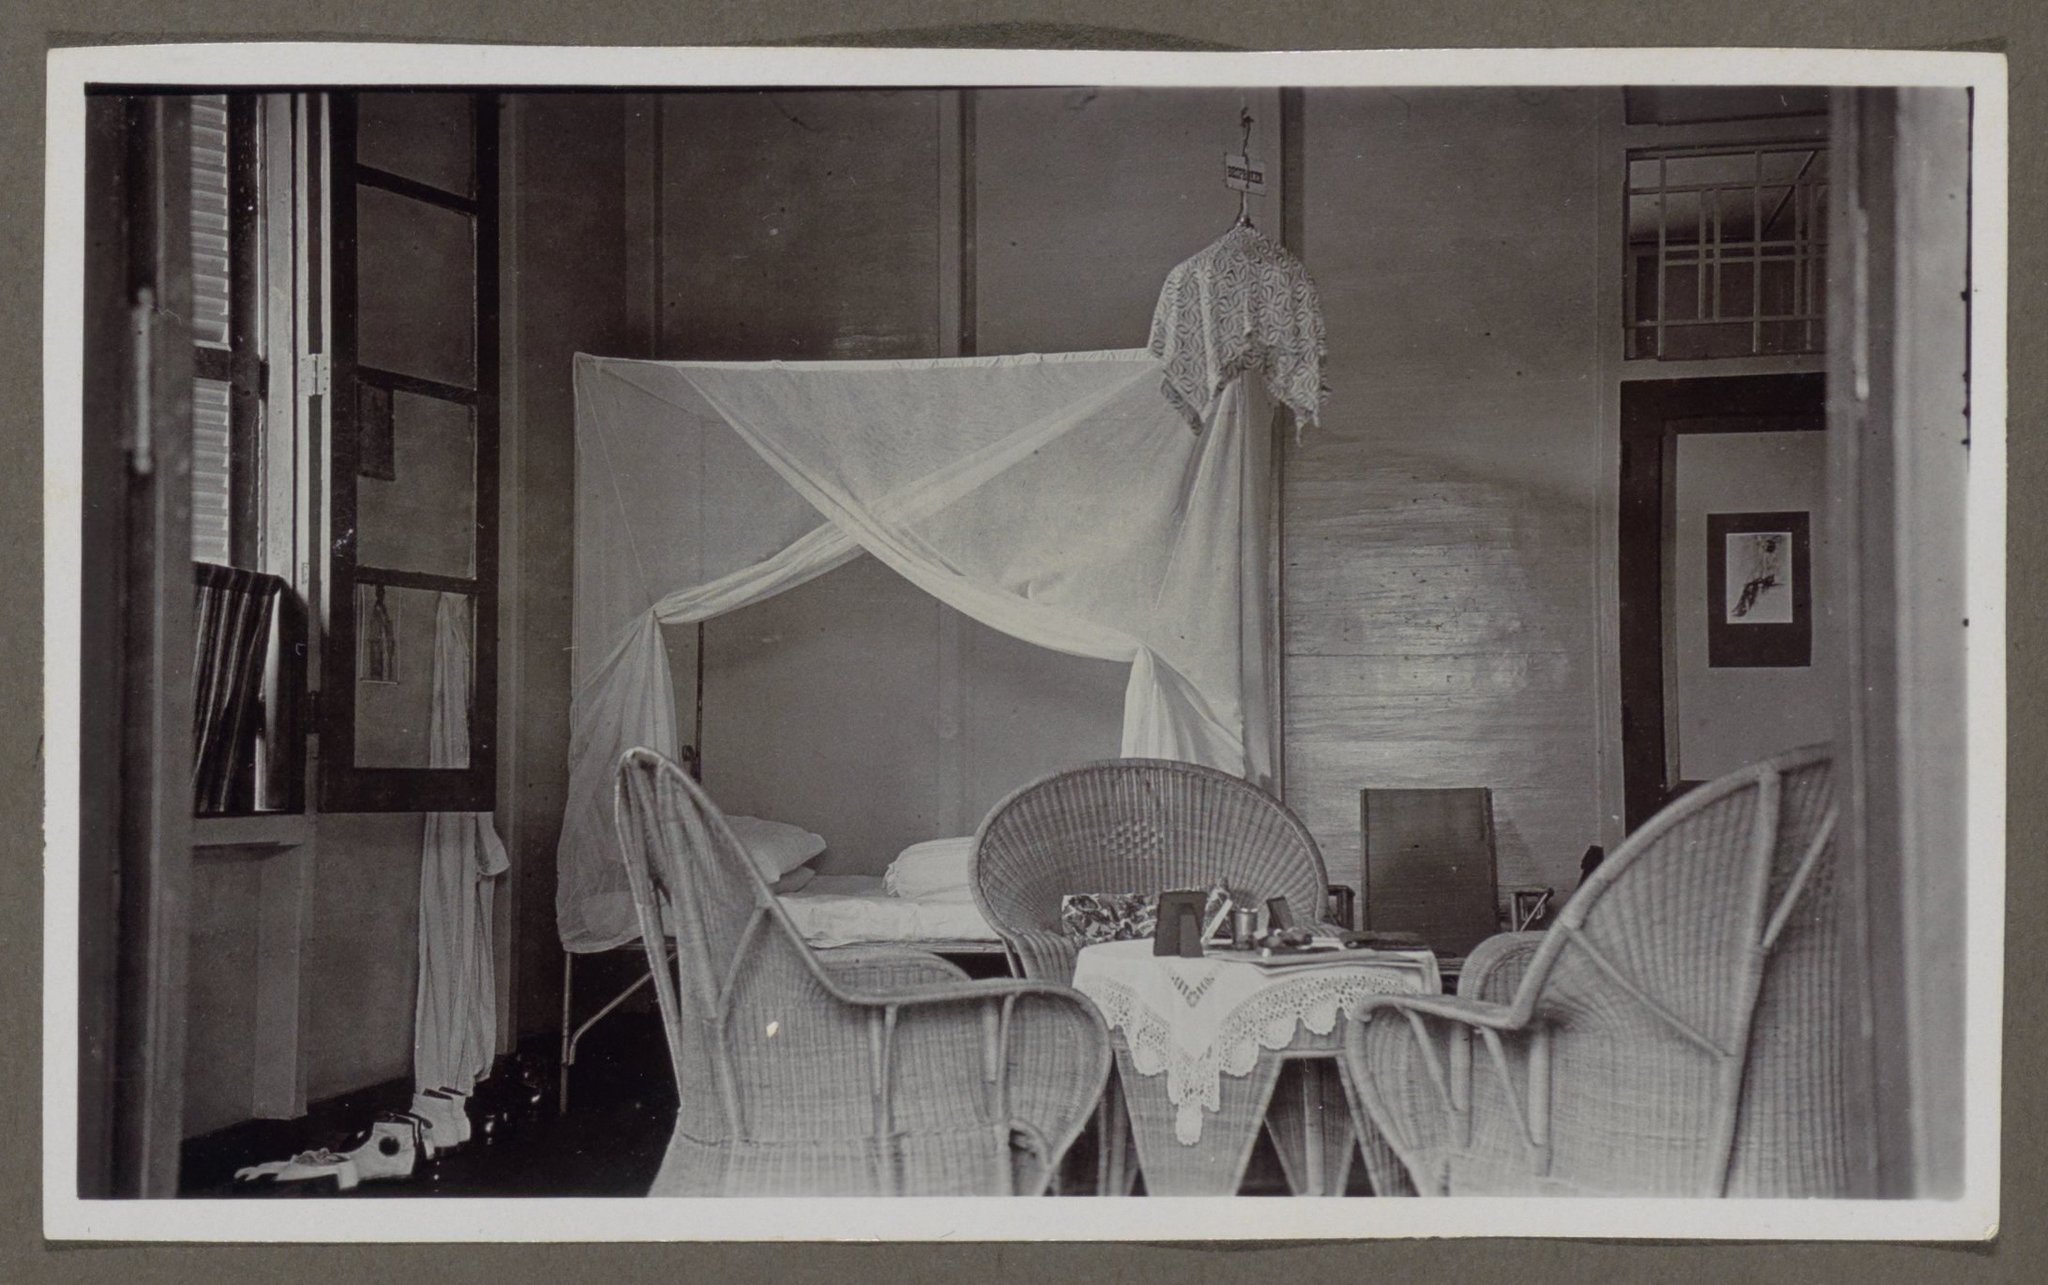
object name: photograph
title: Slaapvertrek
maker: Anonymous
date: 1920-1930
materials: photographic support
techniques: gelatin silver print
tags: bedroom, dutch east indies, the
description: In de hoek van de kamer staat een bed met kussens en een klamboe. Een rieten ameublement staat ervoor. Op tafel staan enkele voorwerpen waaronder een fotolijstje. Boven de tafel een hanglamp. Links op de vloer staat schoeisel, waaronder halfhoge laarzen. Onderdeel van familiealbum Nederlands-Indië.